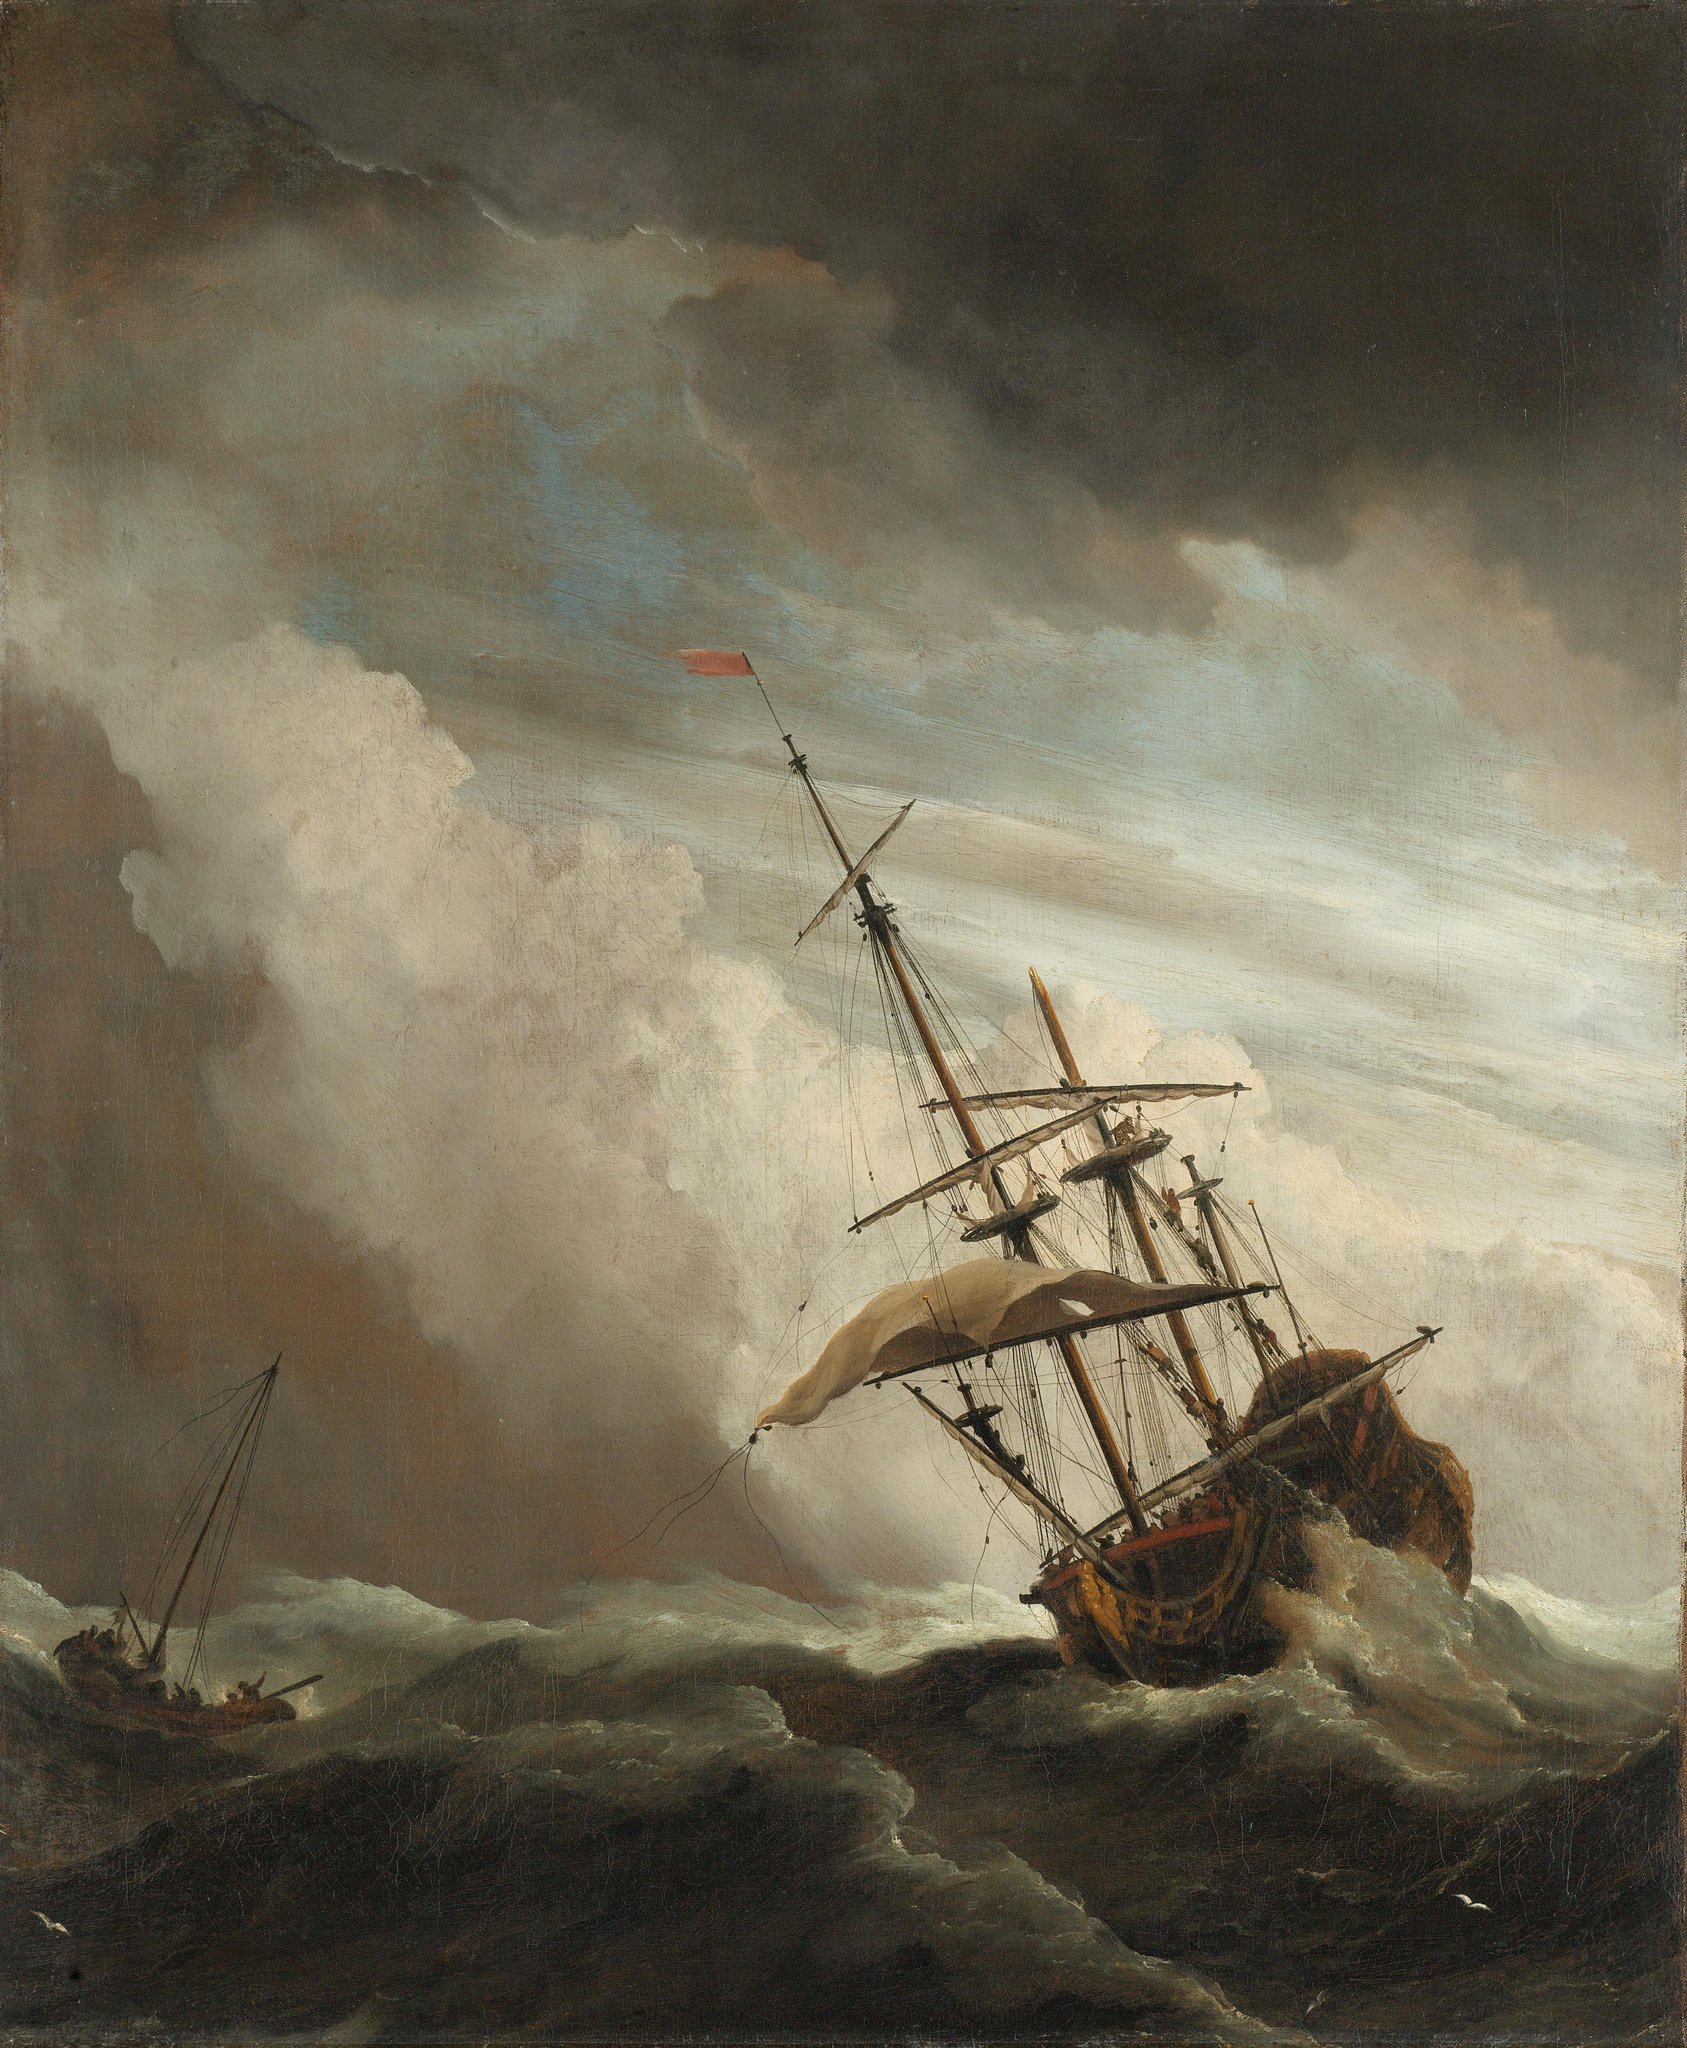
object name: painting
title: A Ship on the High Seas Caught by a Squall, Known as ‘The Gust’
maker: willem van de velde (ii)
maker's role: draughtsman, painter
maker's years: 1633-1707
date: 1680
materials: canvas, oil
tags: sailing-ship, sailing-boat, storm at sea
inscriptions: signature: ‘W. v. Velde f.’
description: This large, 70-gun British warship is in distress. A fierce gust of wind has broken one of its masts, and a sail has come loose. In 1672, Willem van de Velde II, together with his father, who was also a marine painter, entered the service of the English court. He made this painting and its companion, The Cannon Shot, in England.